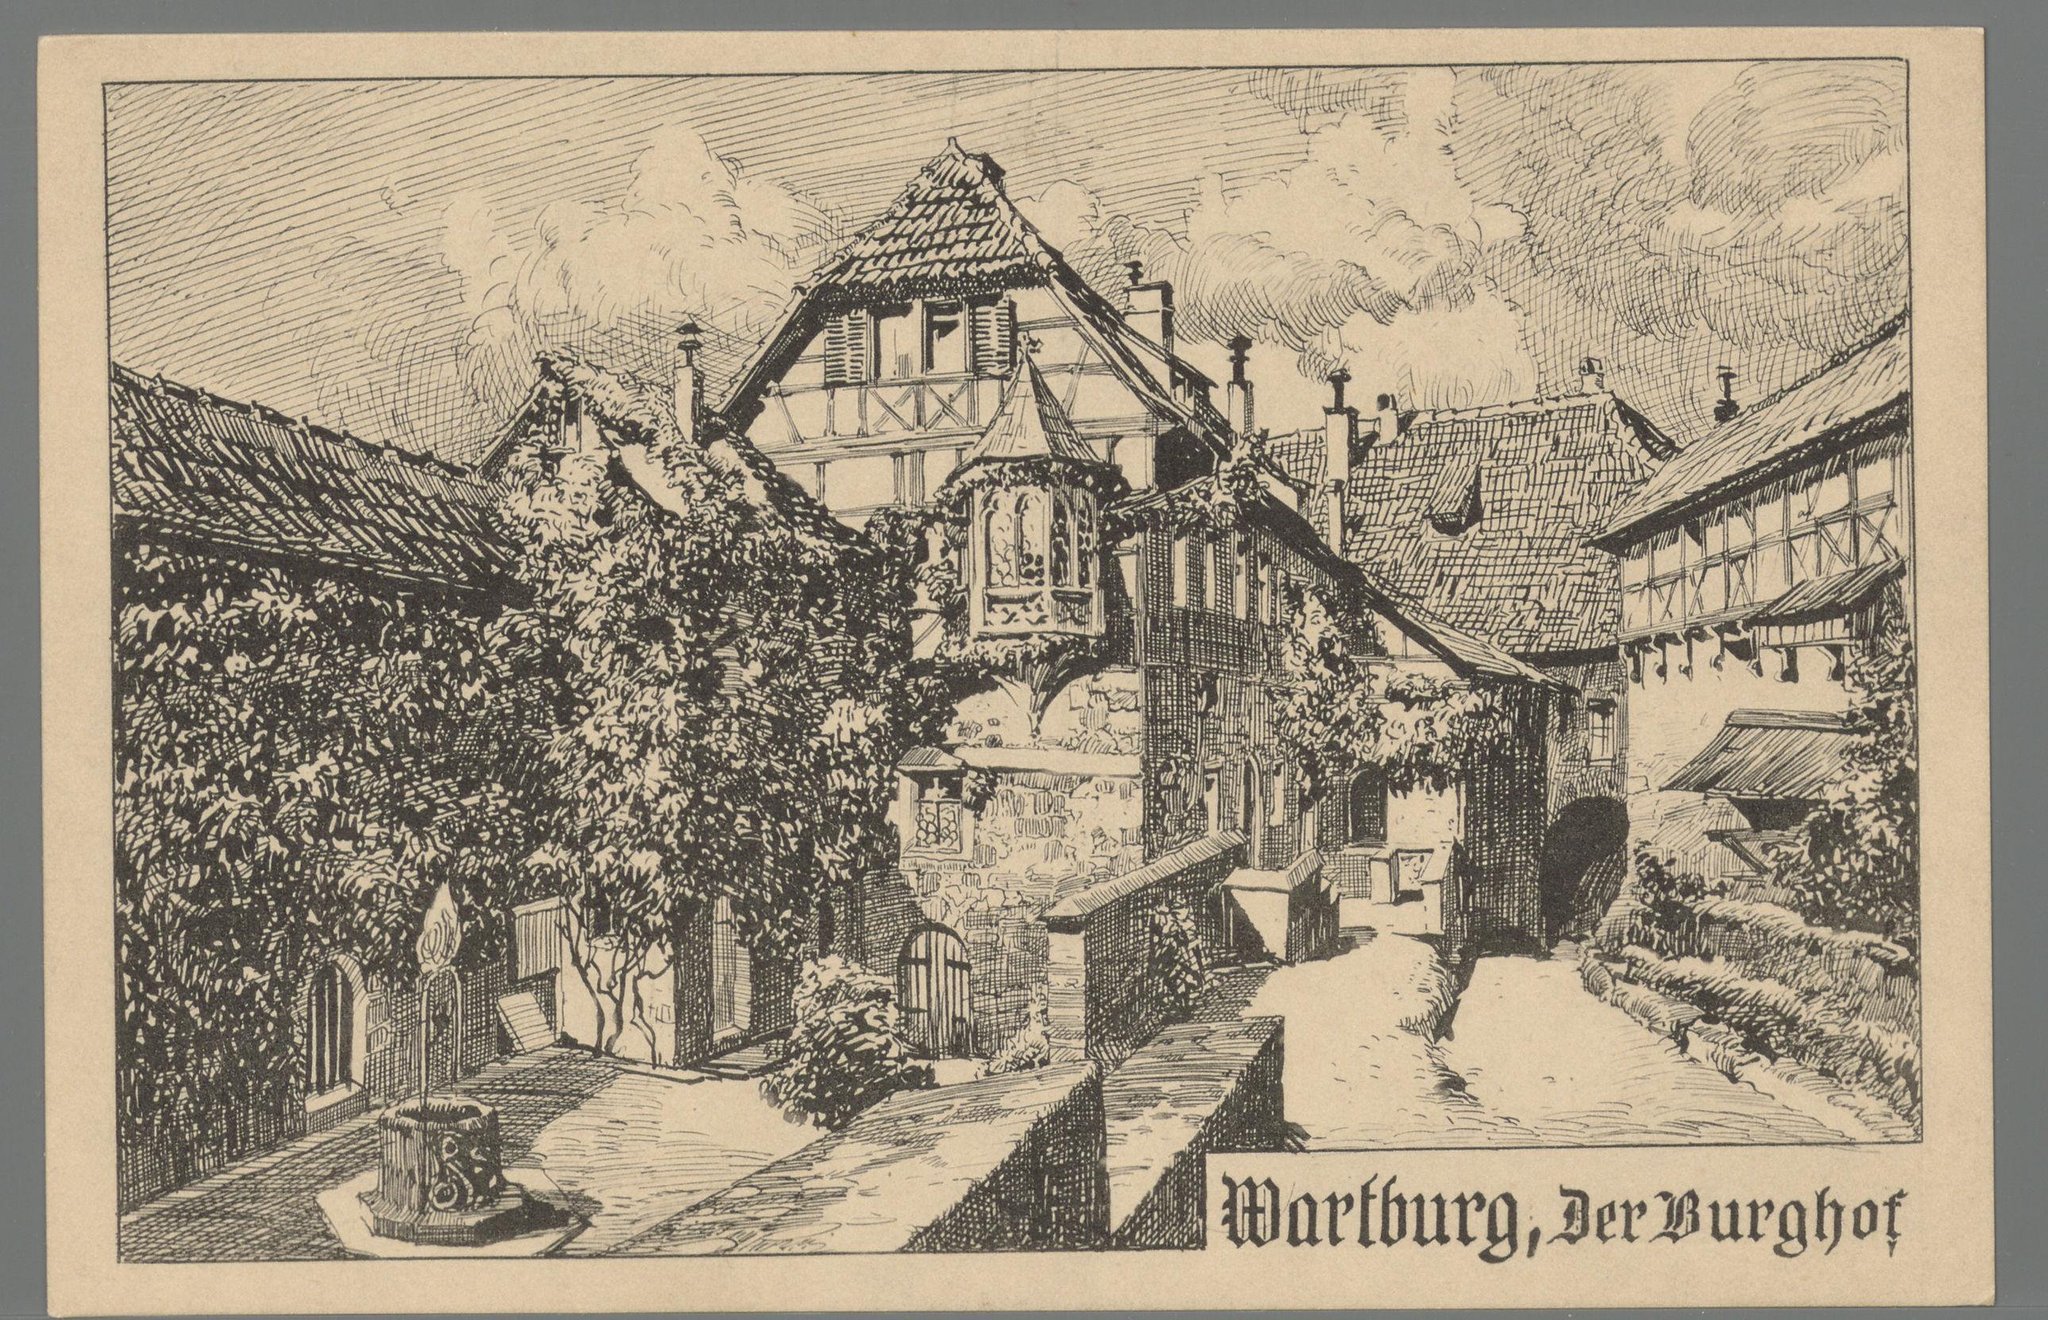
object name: photomechanical print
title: Wartburg, Der Burghof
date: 1913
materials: cardboard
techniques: photograph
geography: gotha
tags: castle, garden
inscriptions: date